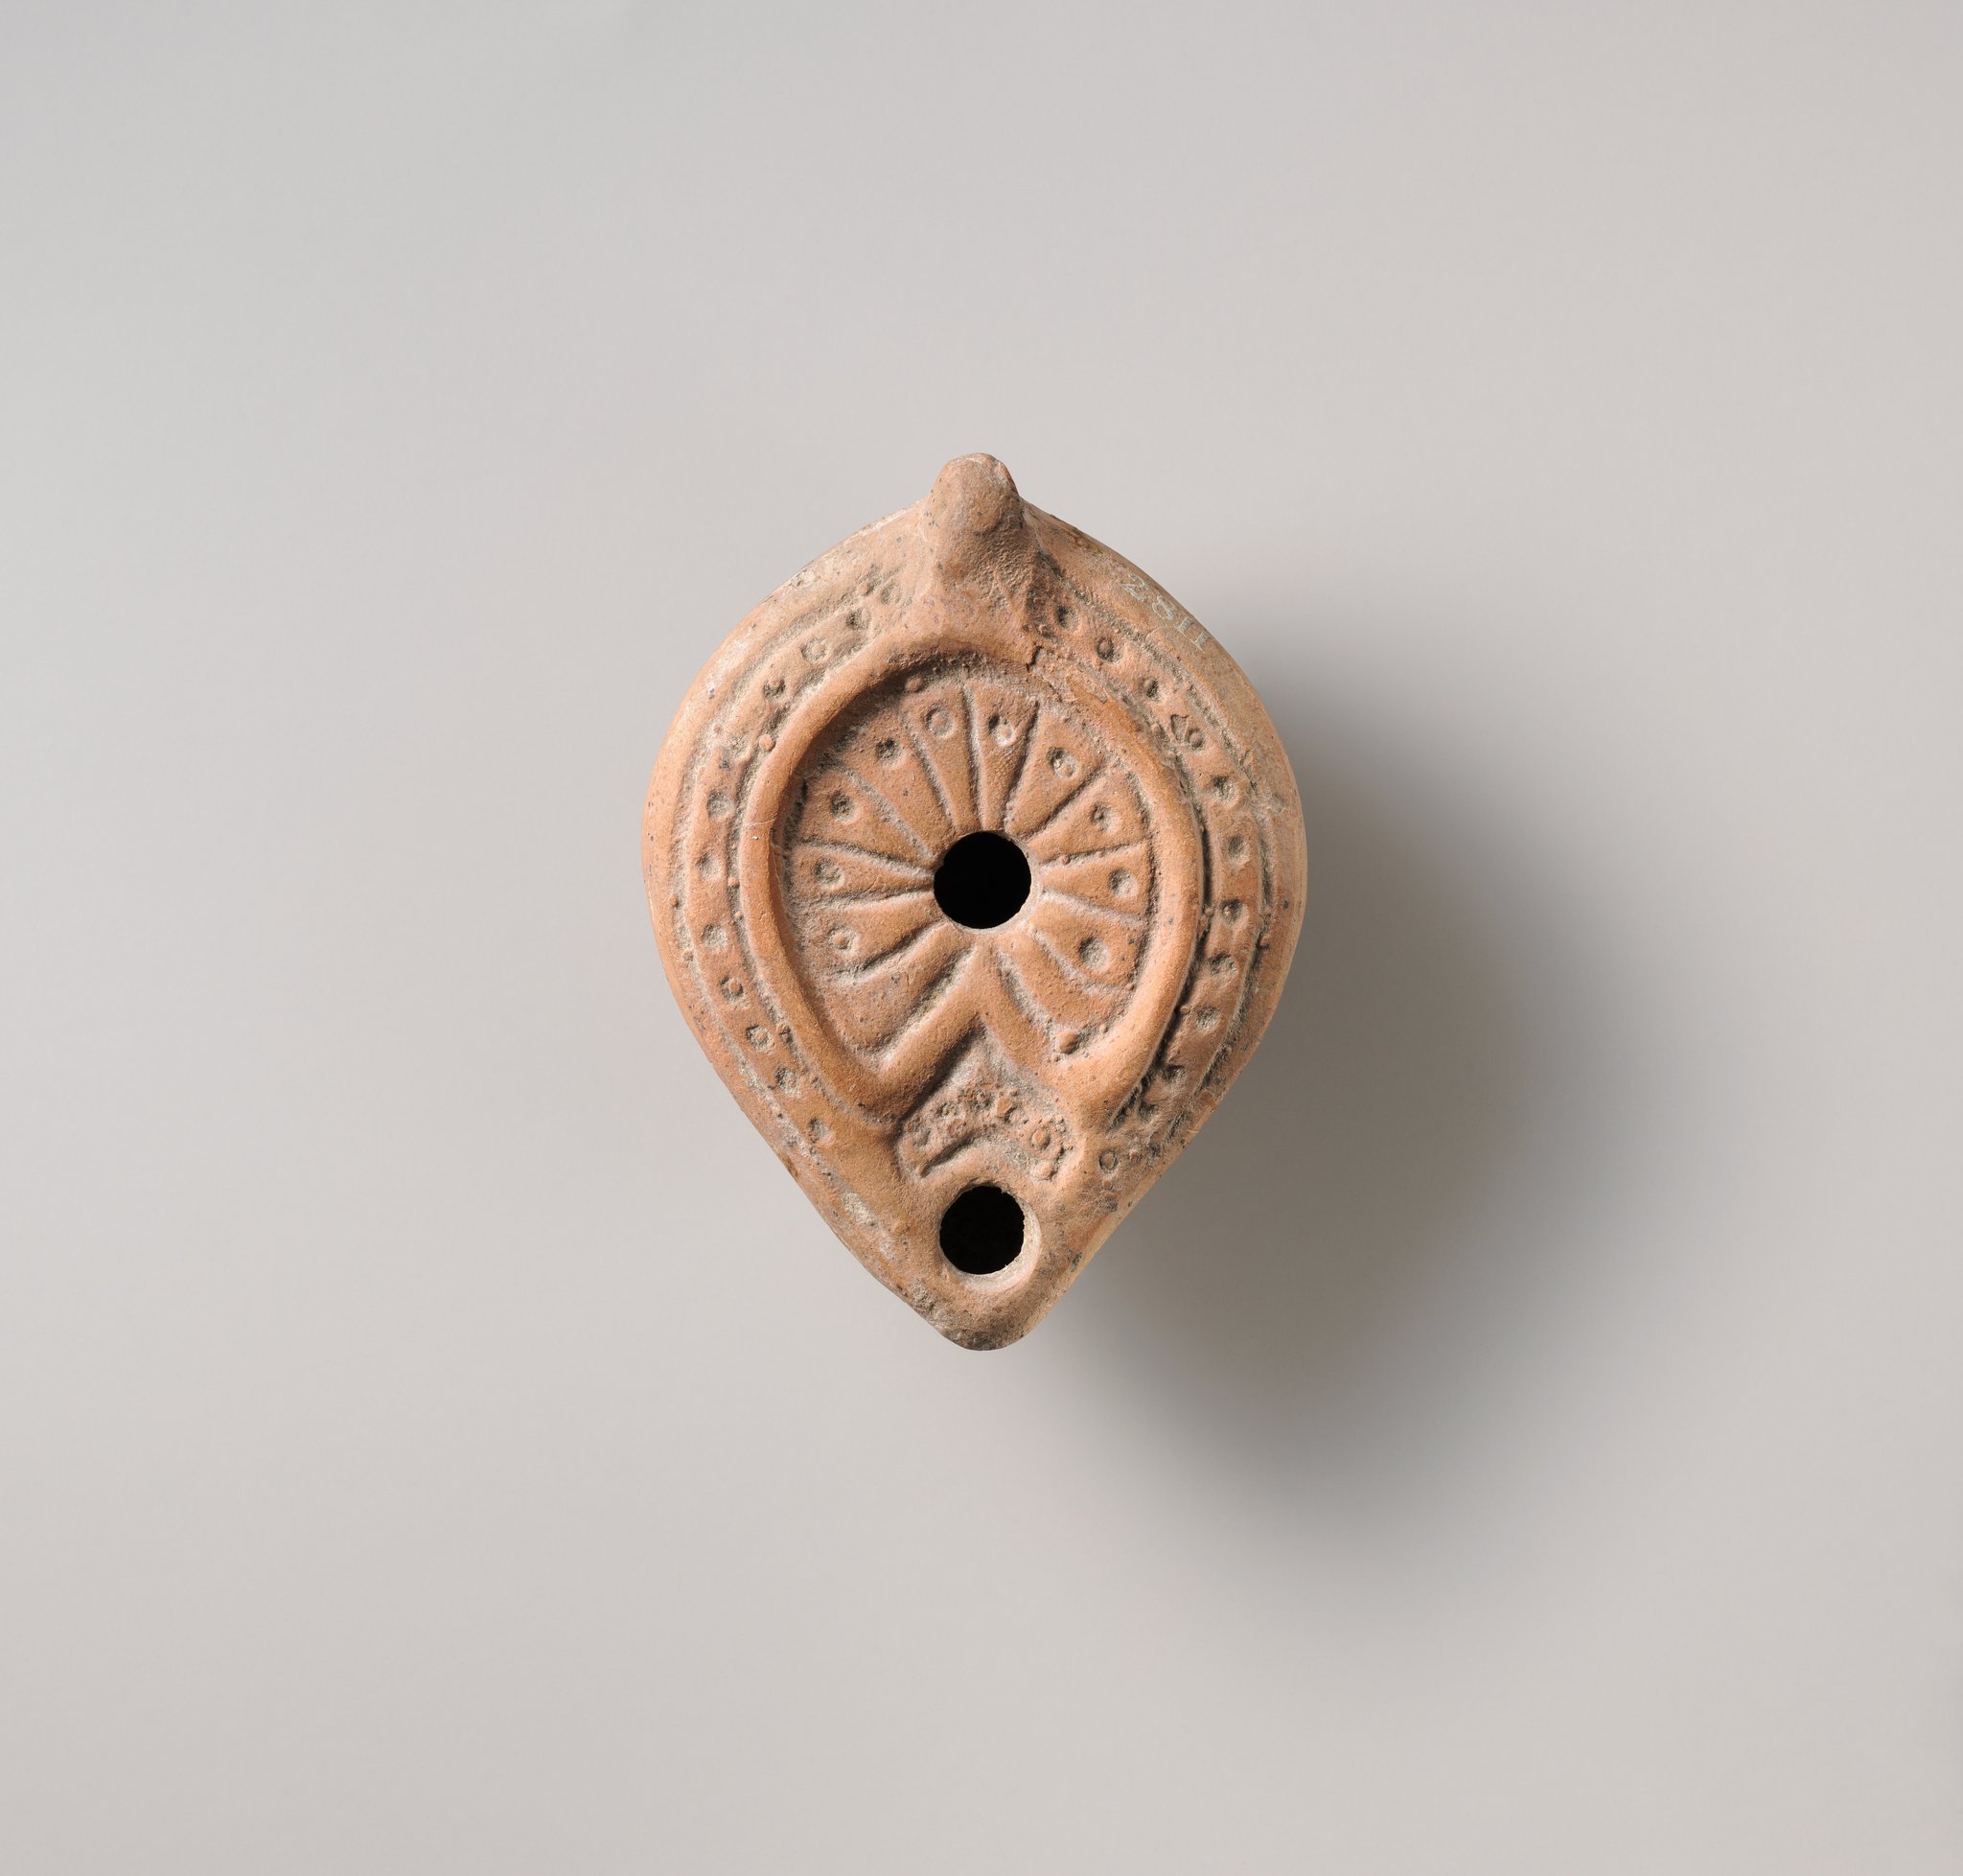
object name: lamp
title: Terracotta oil lamp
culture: roman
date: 401-600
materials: terracotta